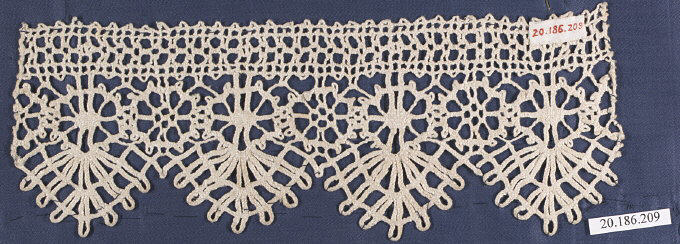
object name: edging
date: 1601-1700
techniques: lace